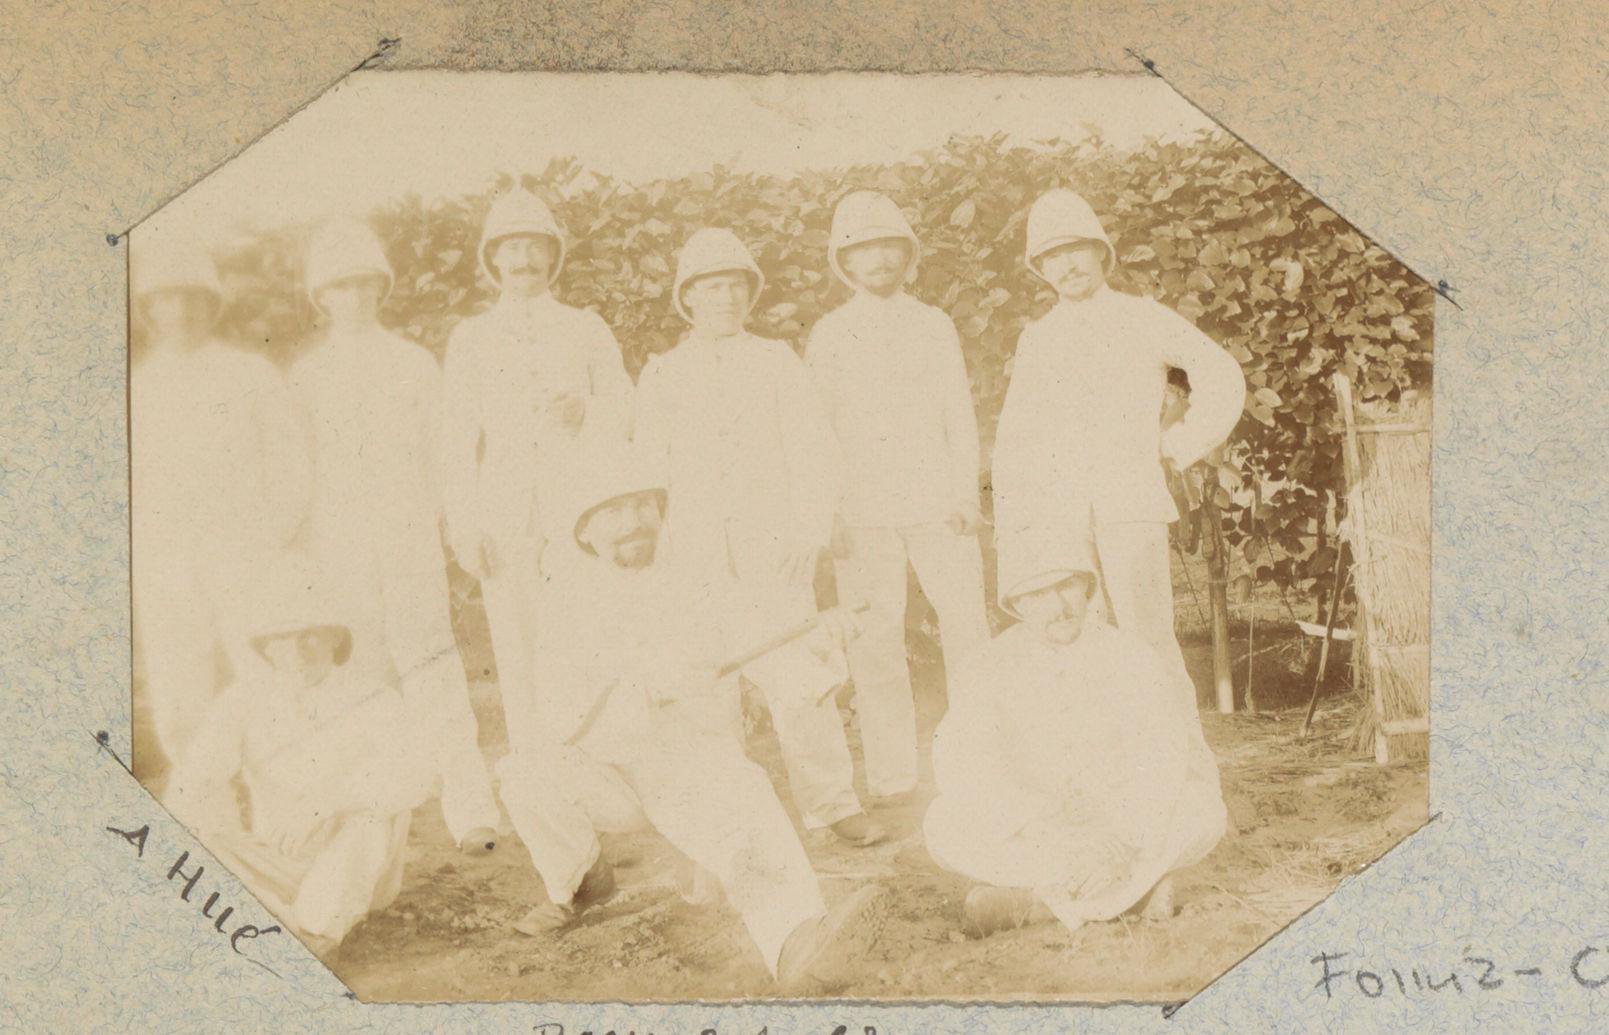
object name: album leaf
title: Groepsportret van negen mannen in tropenkostuum, vermoedelijk Fransen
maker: Anonymous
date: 1880-1900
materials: paper, photographic support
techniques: daylight paper print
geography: france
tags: helmet, (military) uniforms, france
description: Onderdeel van Album van een Franse amateur met foto's van Frankrijk, Algerije, Palmyra, de Wereldtentoonstelling van 1900 en van bekende Fransen.